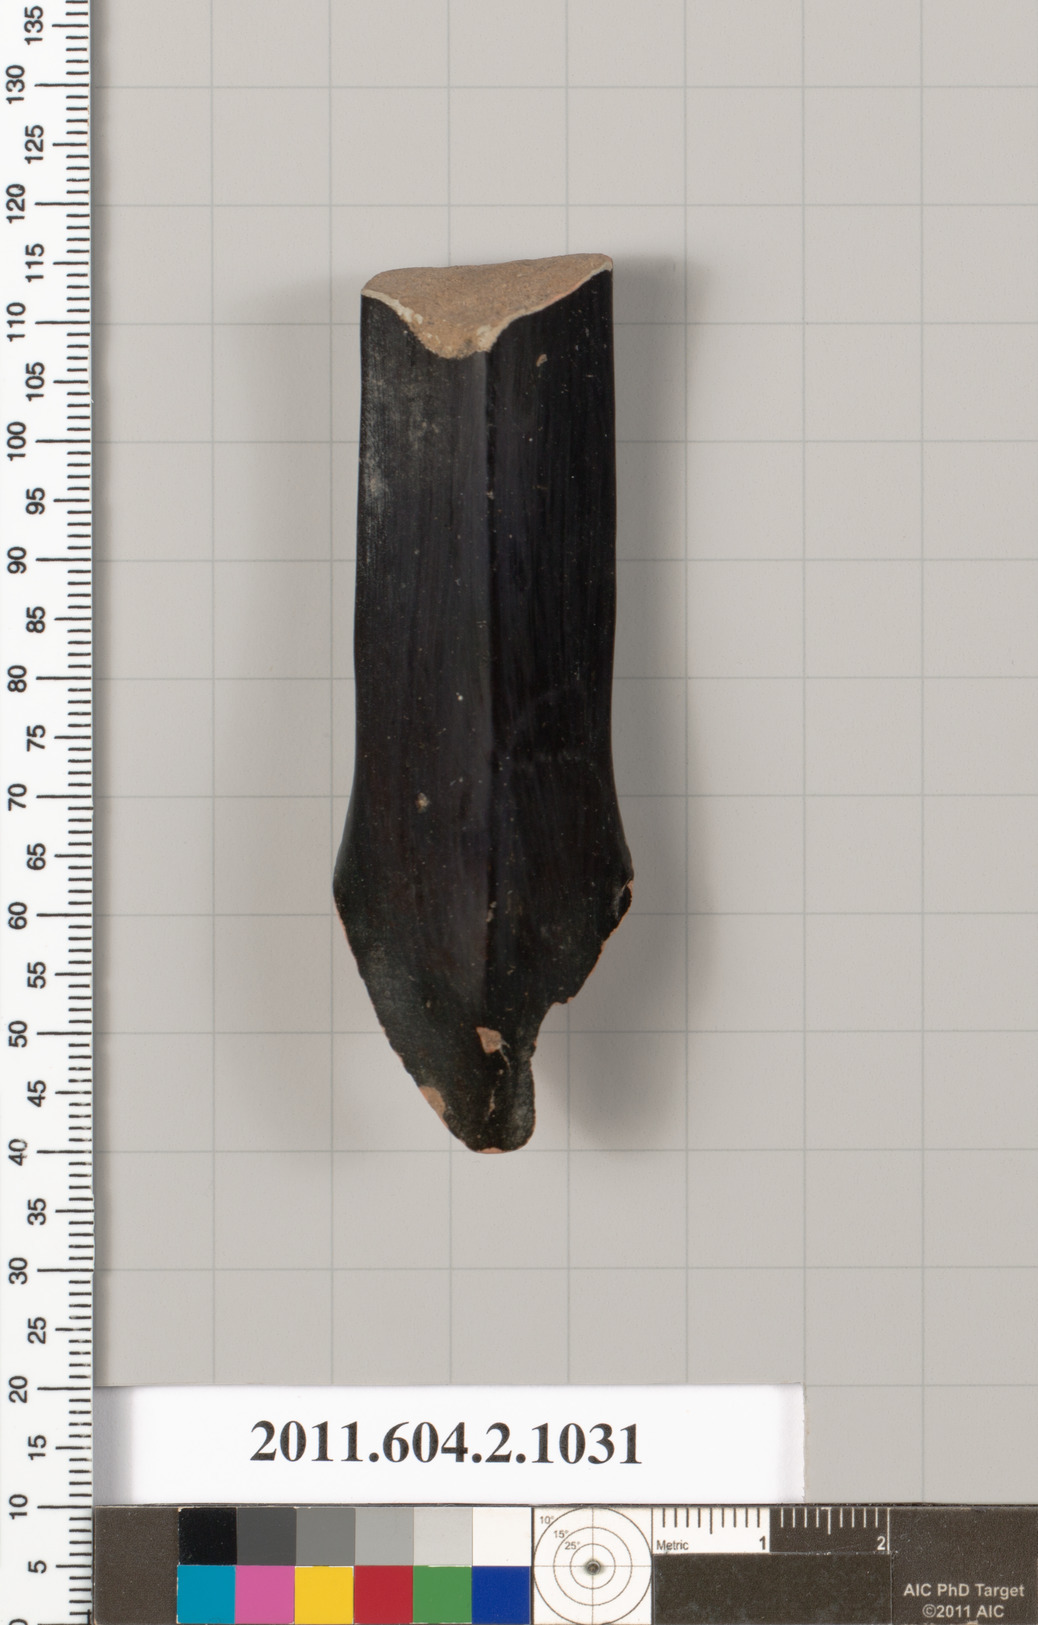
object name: oinochoe fragment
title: Terracotta fragment of an oinochoe (jug)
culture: greek, attic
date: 450-426 BCE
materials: terracotta